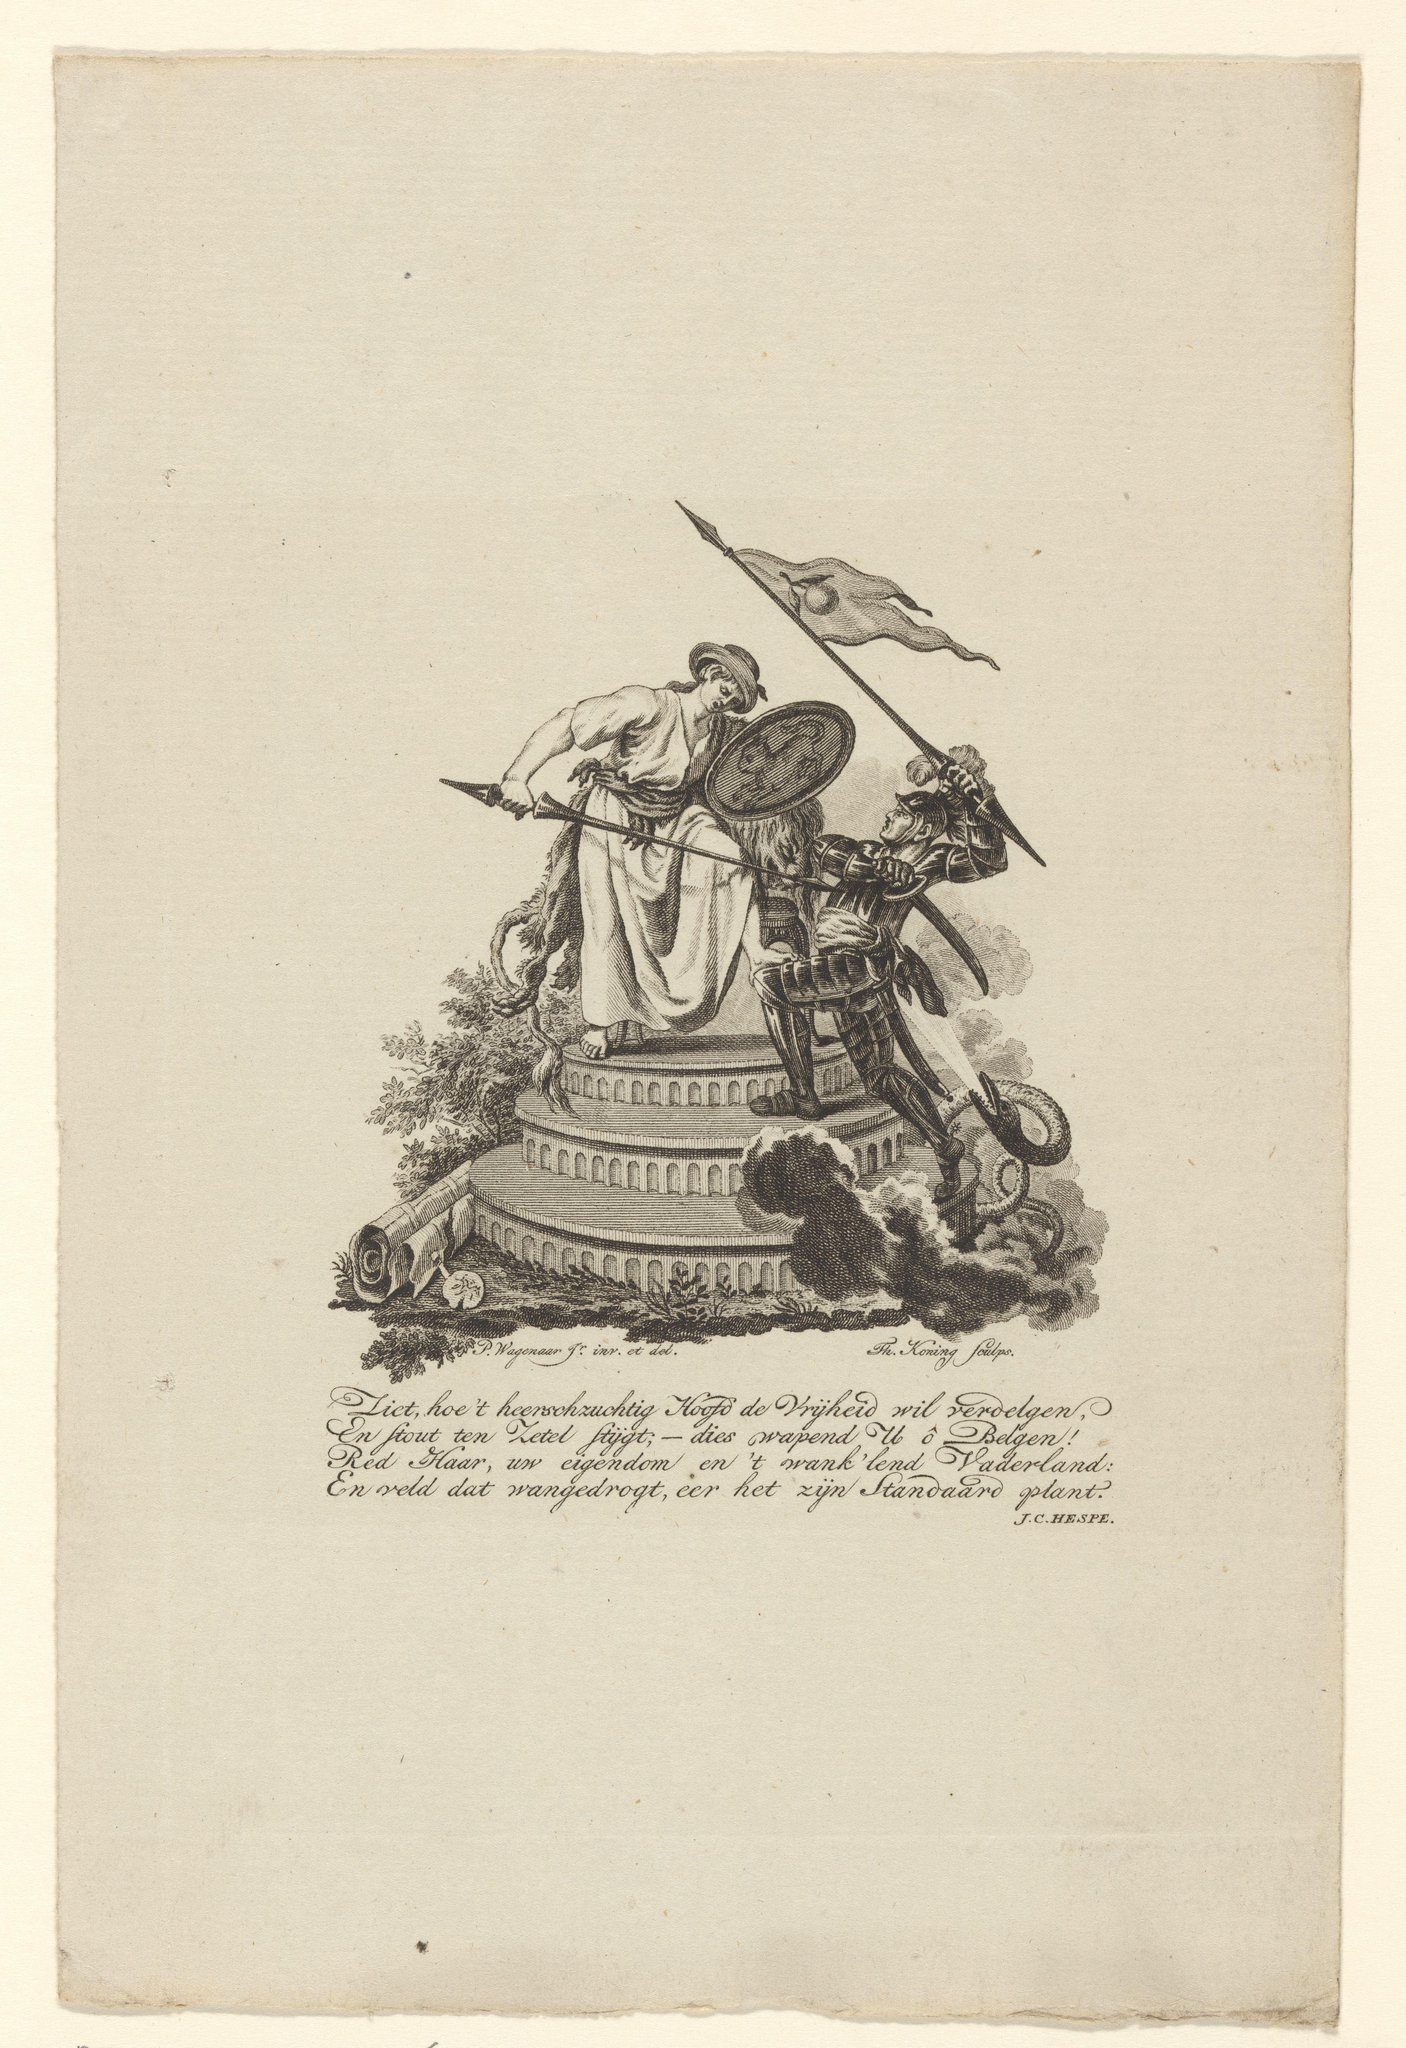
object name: print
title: Allegorie op de Nederlandse Vrijheid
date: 1783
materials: paper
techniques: engraving, etching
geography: northern netherlands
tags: freedom, liberty; 'libertà' (ripa) (+ abstract concept represented by female figure), patriots (1780-1795)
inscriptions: collector's mark: Lugt 2228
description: Gebruikt als illustratie in het tijdschrift: De politieke kruyer. Amsterdam: Jan Verlem, verschenen in 10 delen, 1783-1787.